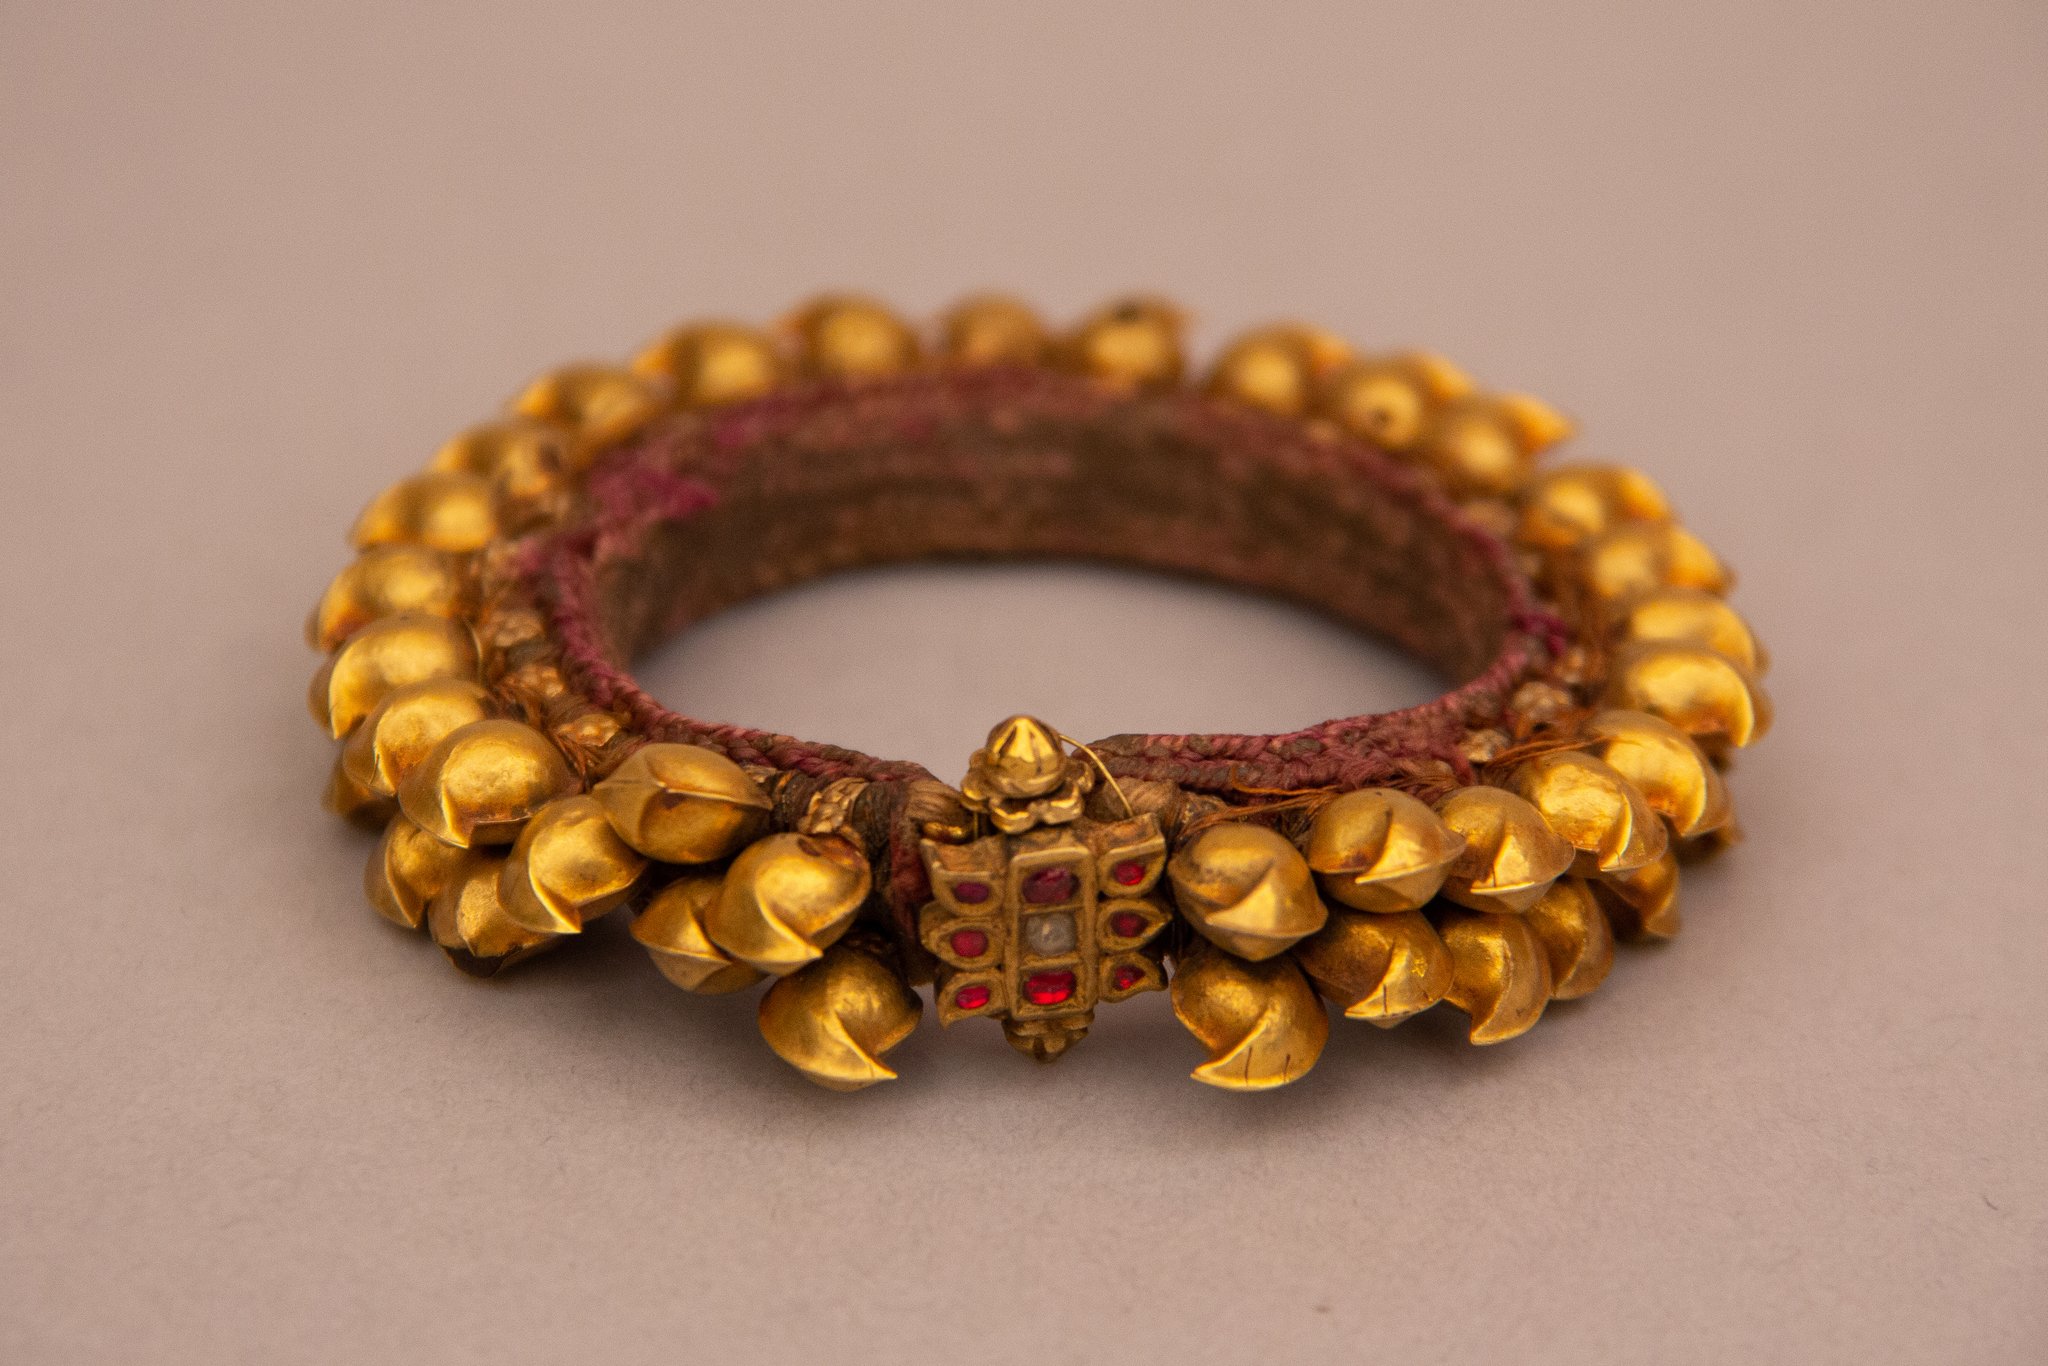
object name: bracelet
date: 1701-1900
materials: gold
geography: northern india